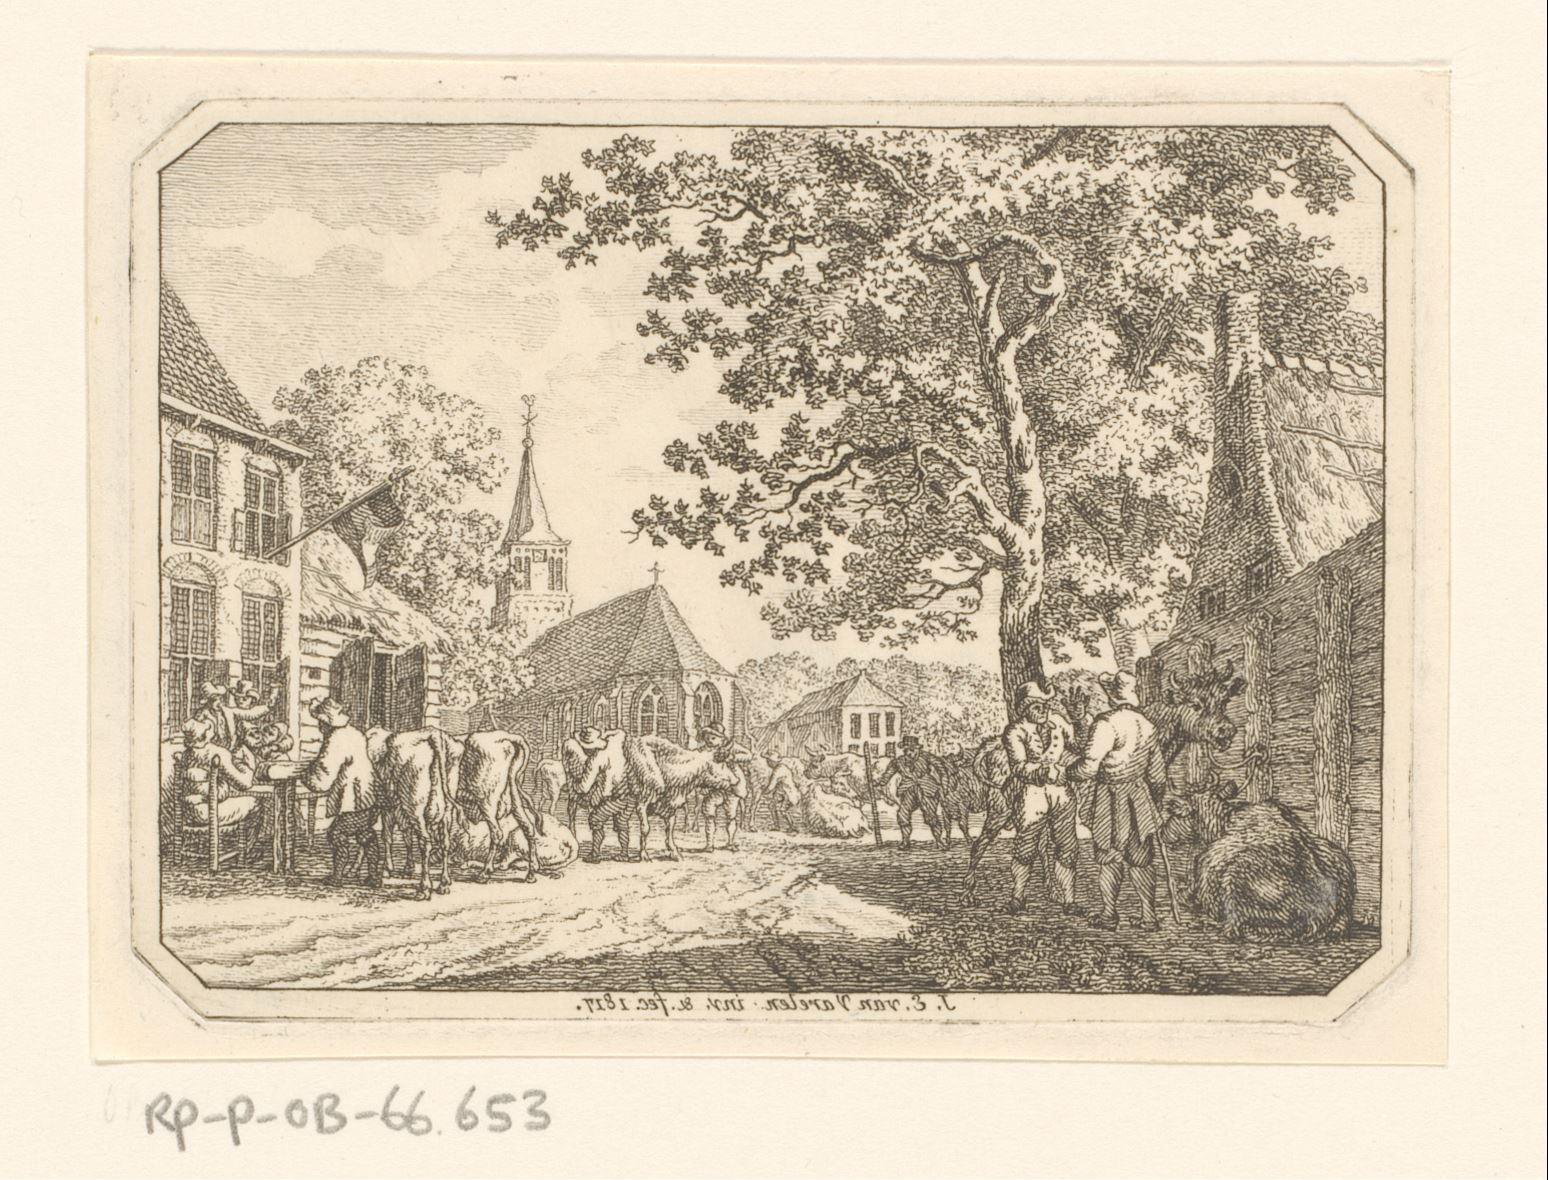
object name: print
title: Dorp met kerk en koeienmarkt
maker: jacob elias van varelen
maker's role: draughtsman, print maker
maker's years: 1757-1840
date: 1817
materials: paper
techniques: etching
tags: cow, church (exterior), market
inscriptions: collector's mark: Lugt 2228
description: Prent diende mogelijk als illustratie voor de deksel van een tabaksdoos.